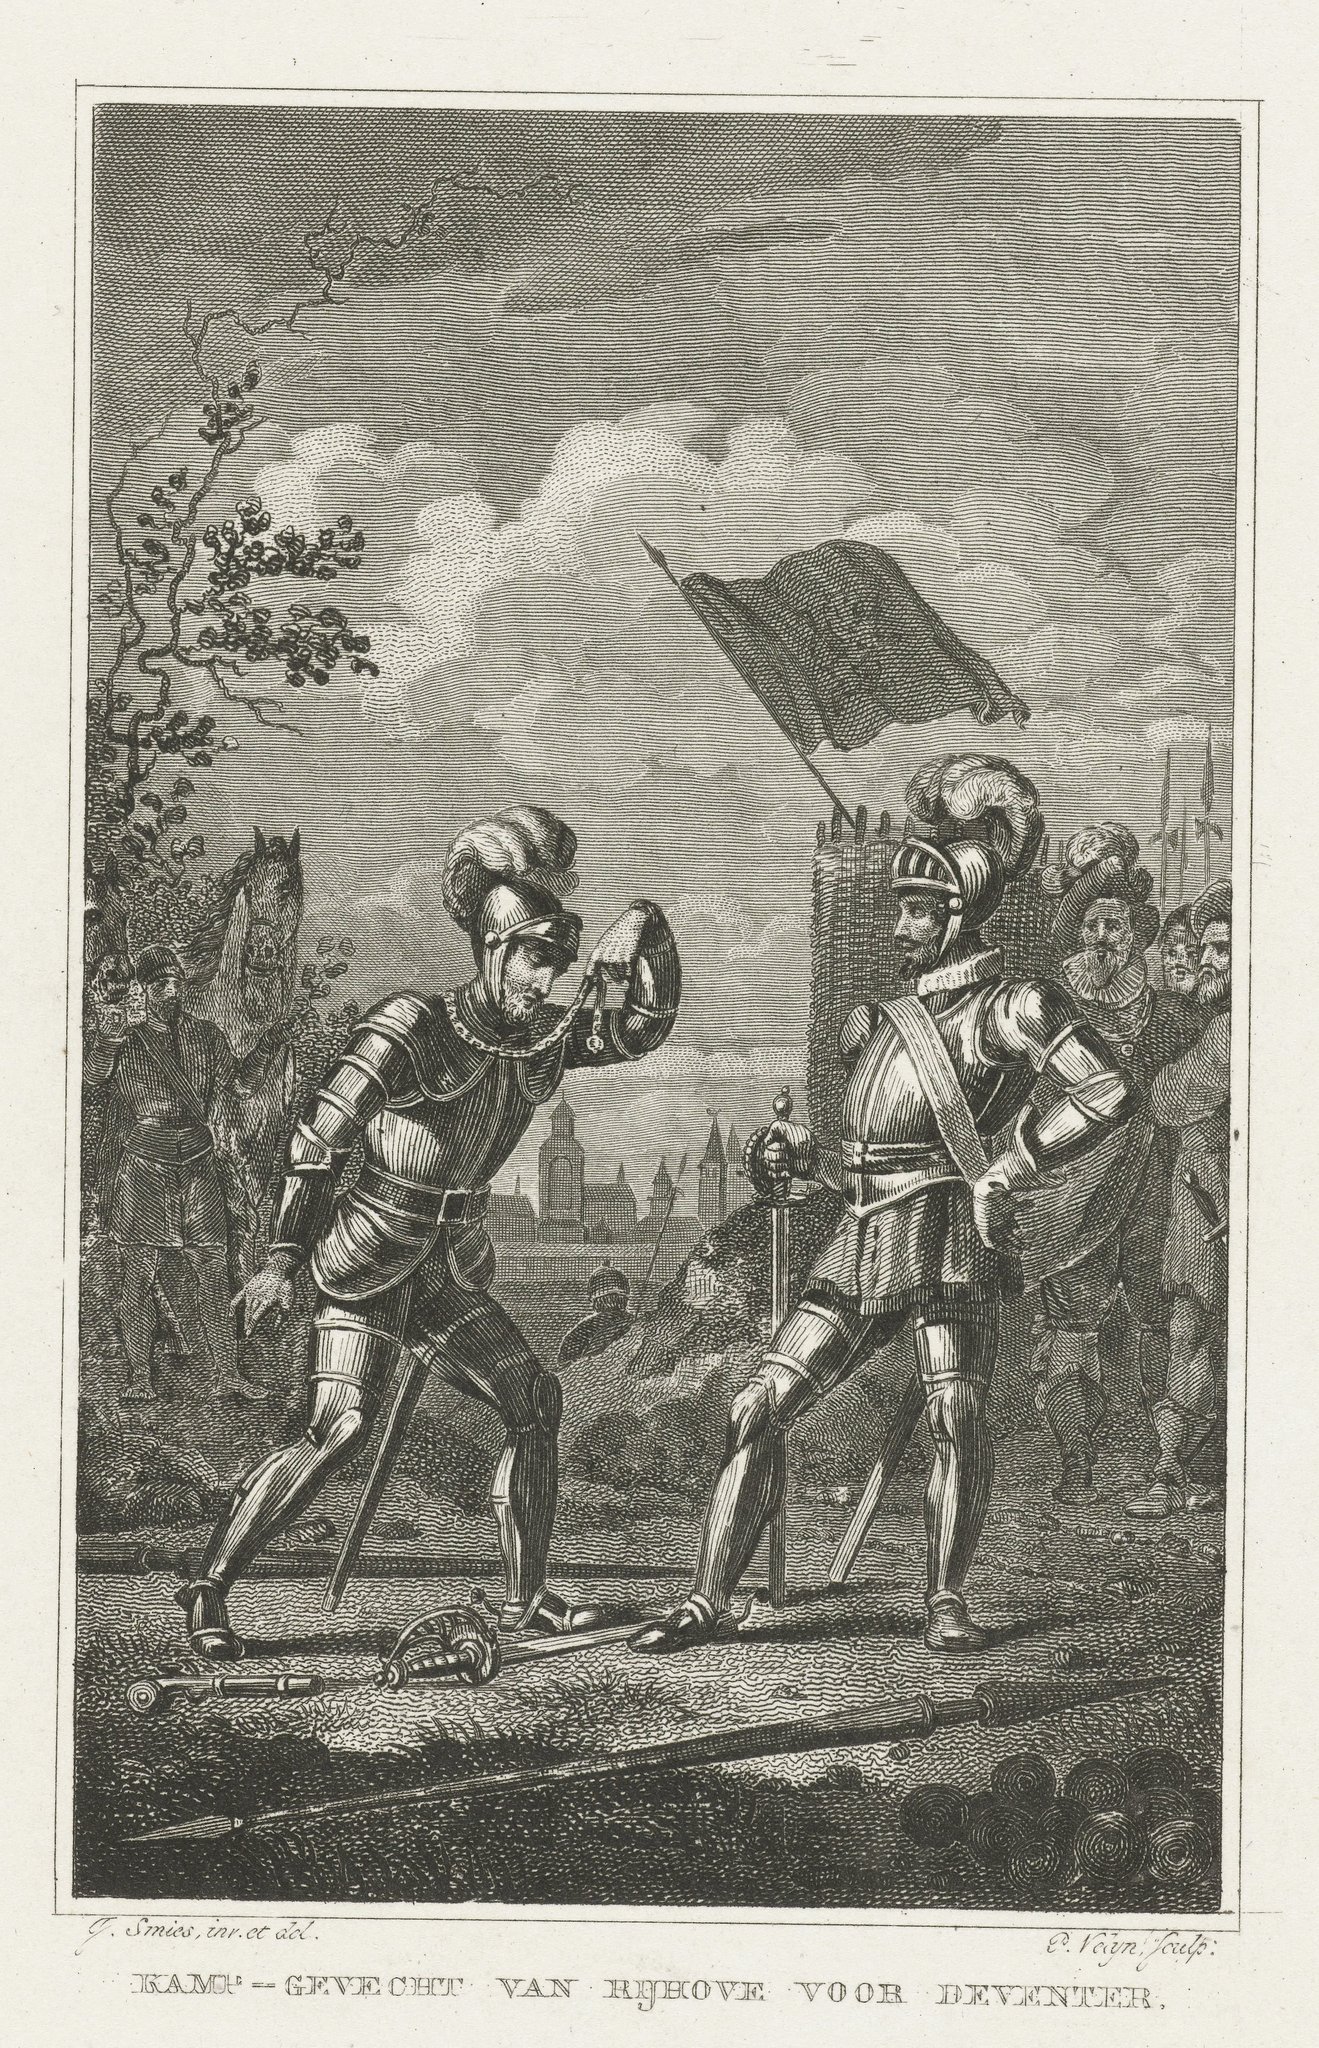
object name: print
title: Lodewijk van der Kethulle verslaat de Spaanse ruiter, 1591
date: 1823-1829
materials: paper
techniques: etching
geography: netherlands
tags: duelling, deventer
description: Gebruikt als illustratie in: P.G. Witsen Geysbeek en G. Engelberts Gerrits, Schoonheden en merkwaardige tafereelen uit de Nederlandsche geschiedenis. G. Portielje, Amsterdam 1825-1829, 8 delen.